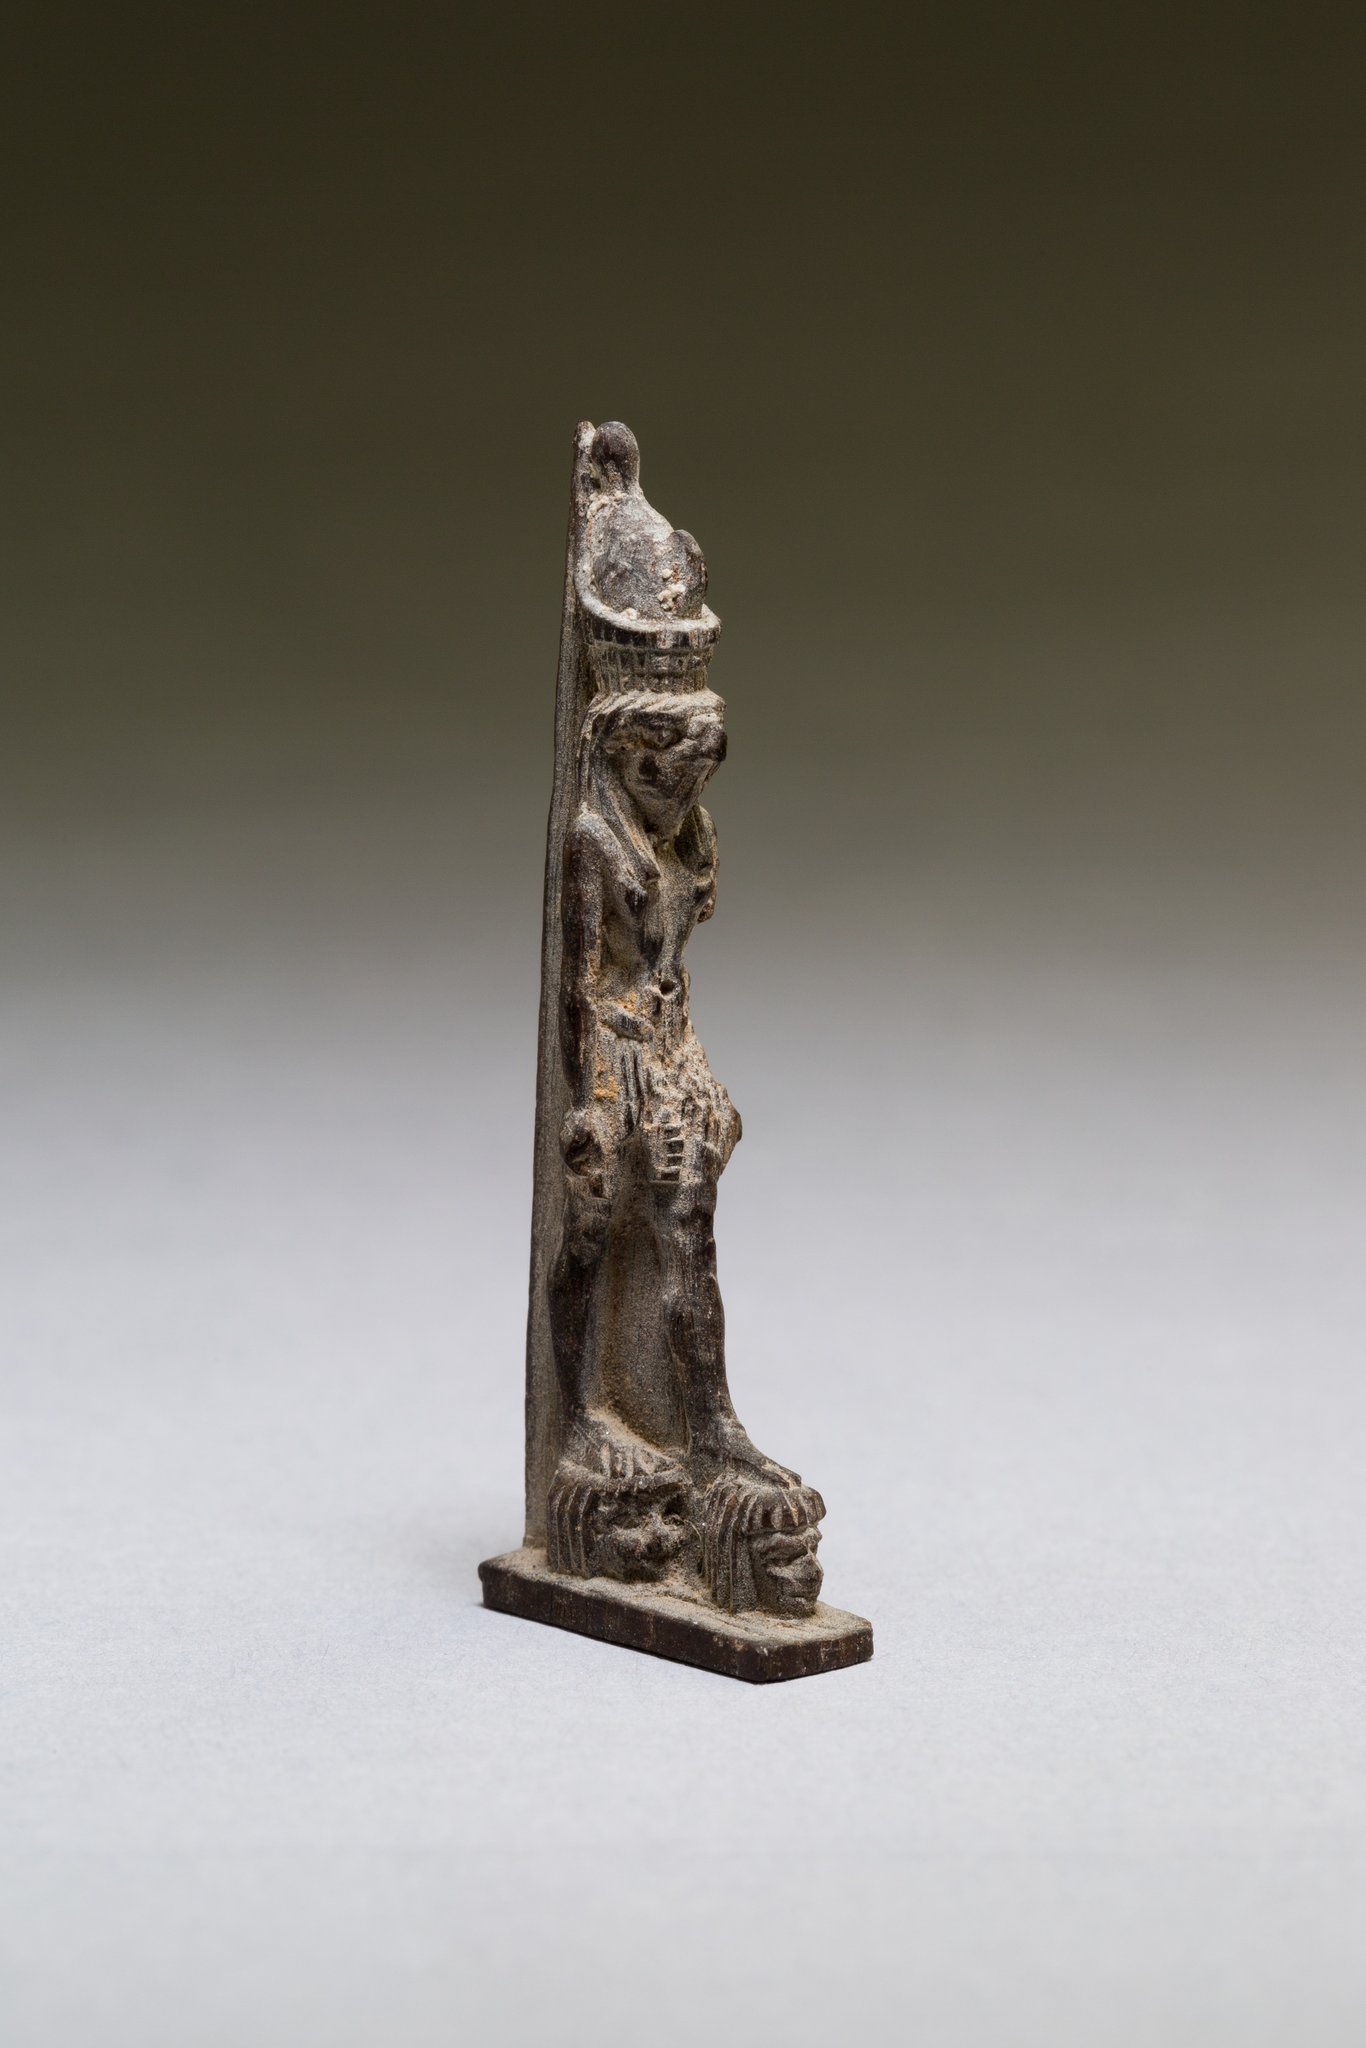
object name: figurine, horus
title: Horus standing on two captives' heads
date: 664-630 BCE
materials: wood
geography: egypt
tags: heads,horus